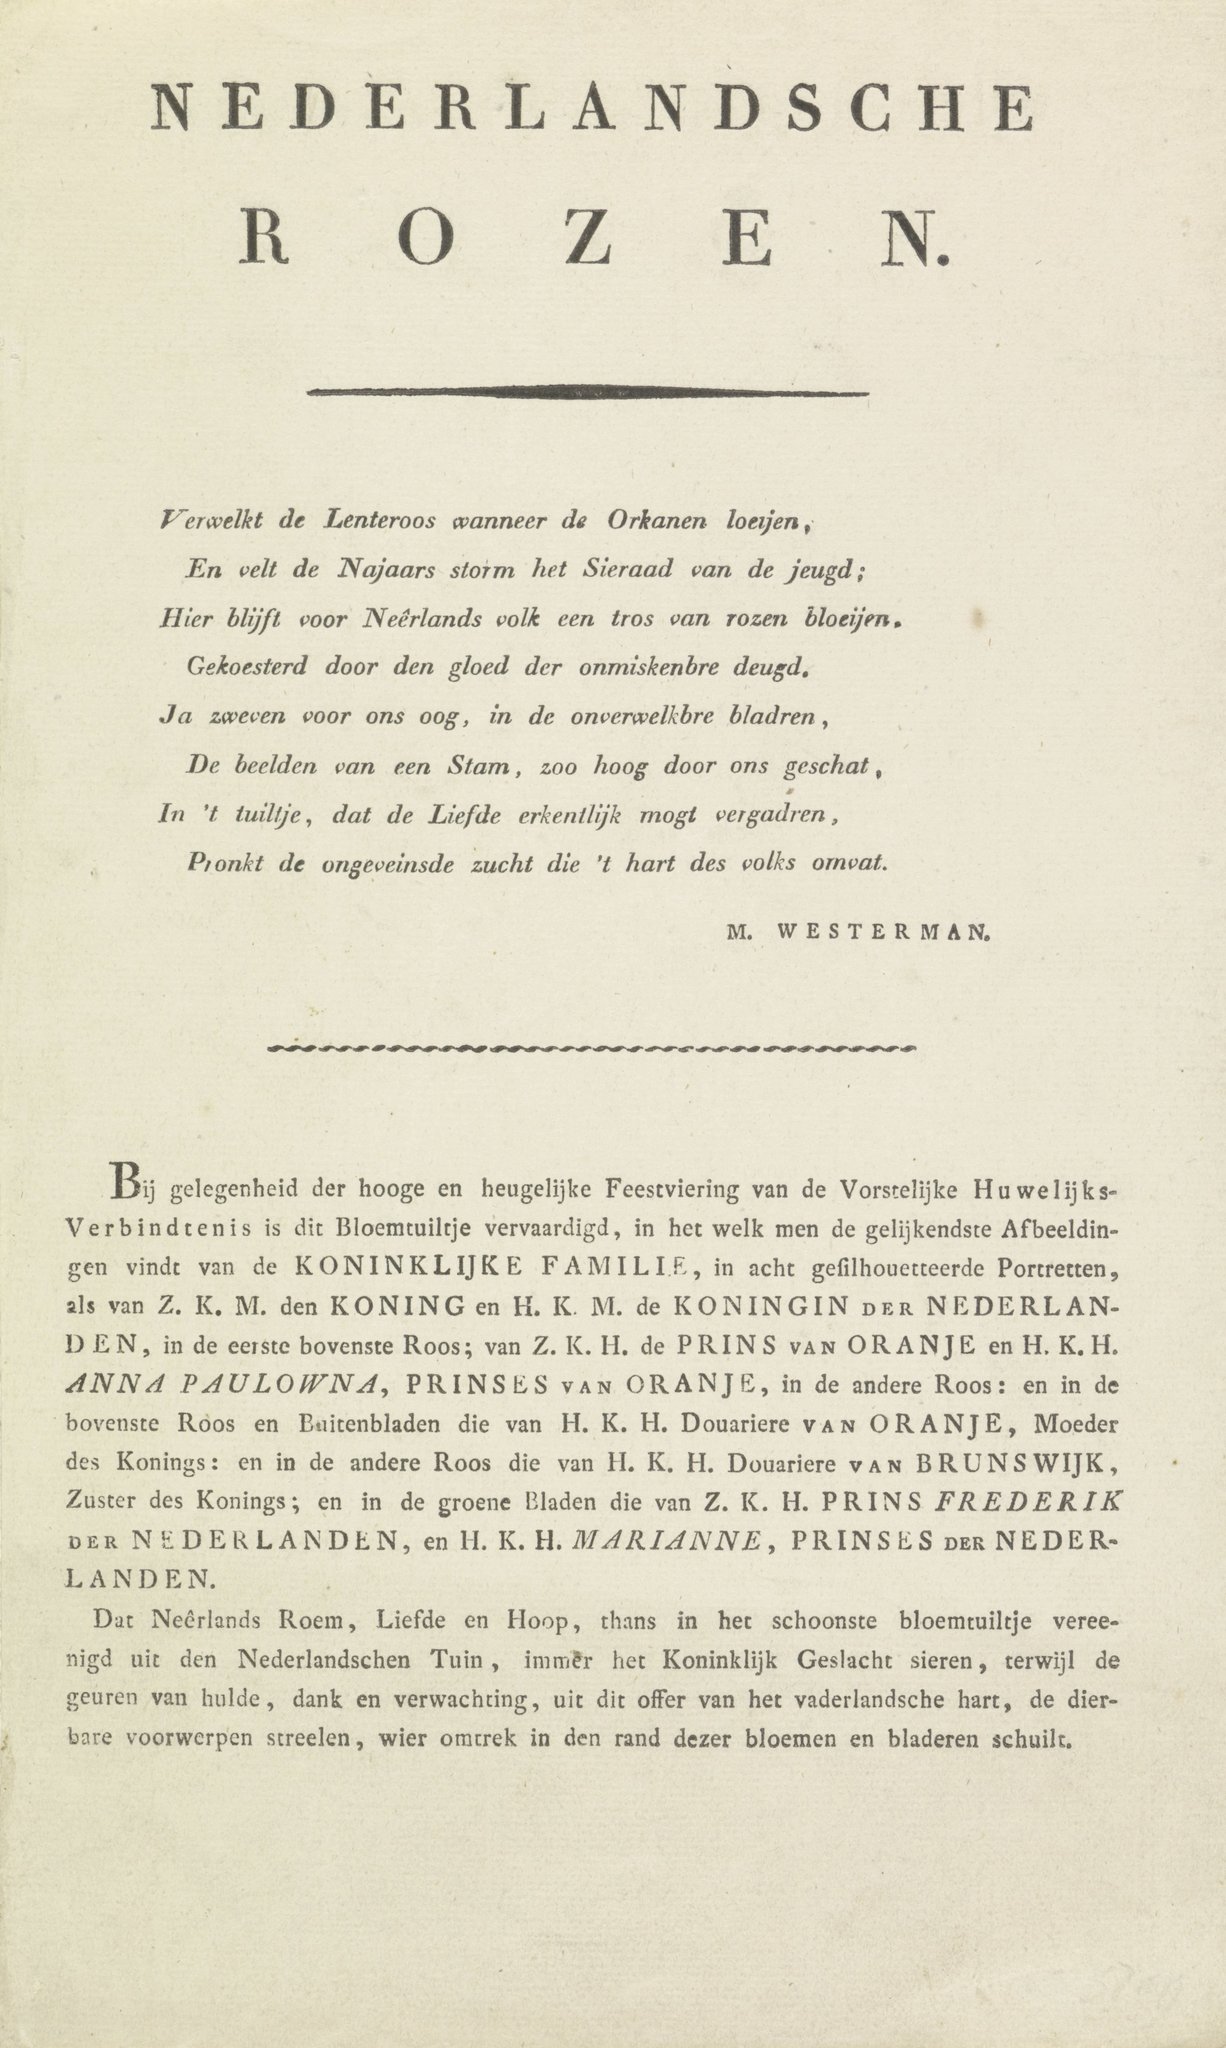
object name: text sheet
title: Nederlandsche Rozen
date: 1816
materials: paper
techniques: letterpress printing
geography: amsterdam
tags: anna paulowna romanowa, william i of the netherlands, william ii of the netherlands, painter, draughtsman, wilhelmina of prussia (princess of orange), amsterdam, louise (prinses van oranje-nassau), frederik (prins der nederlanden), voorburg, marianne (prinses der nederlanden), berlin, the hague, wilhelmina frederica louisa (koningin der nederlanden), flowers: rose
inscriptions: collector's mark: Lugt 2228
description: Tekstblad met een gedicht en de verklaring van de voorstelling van de prent met het boeket rozen waarin de silhouetten van de Koninklijke familie zijn verwerkt. Naar aanleiding van het huwelijk van de prins van Oranje en Anna Paulowna te Sint Petersburg op 21 februari 1816. Bovenaan hetzelfde achtregelige vers als op de prent.